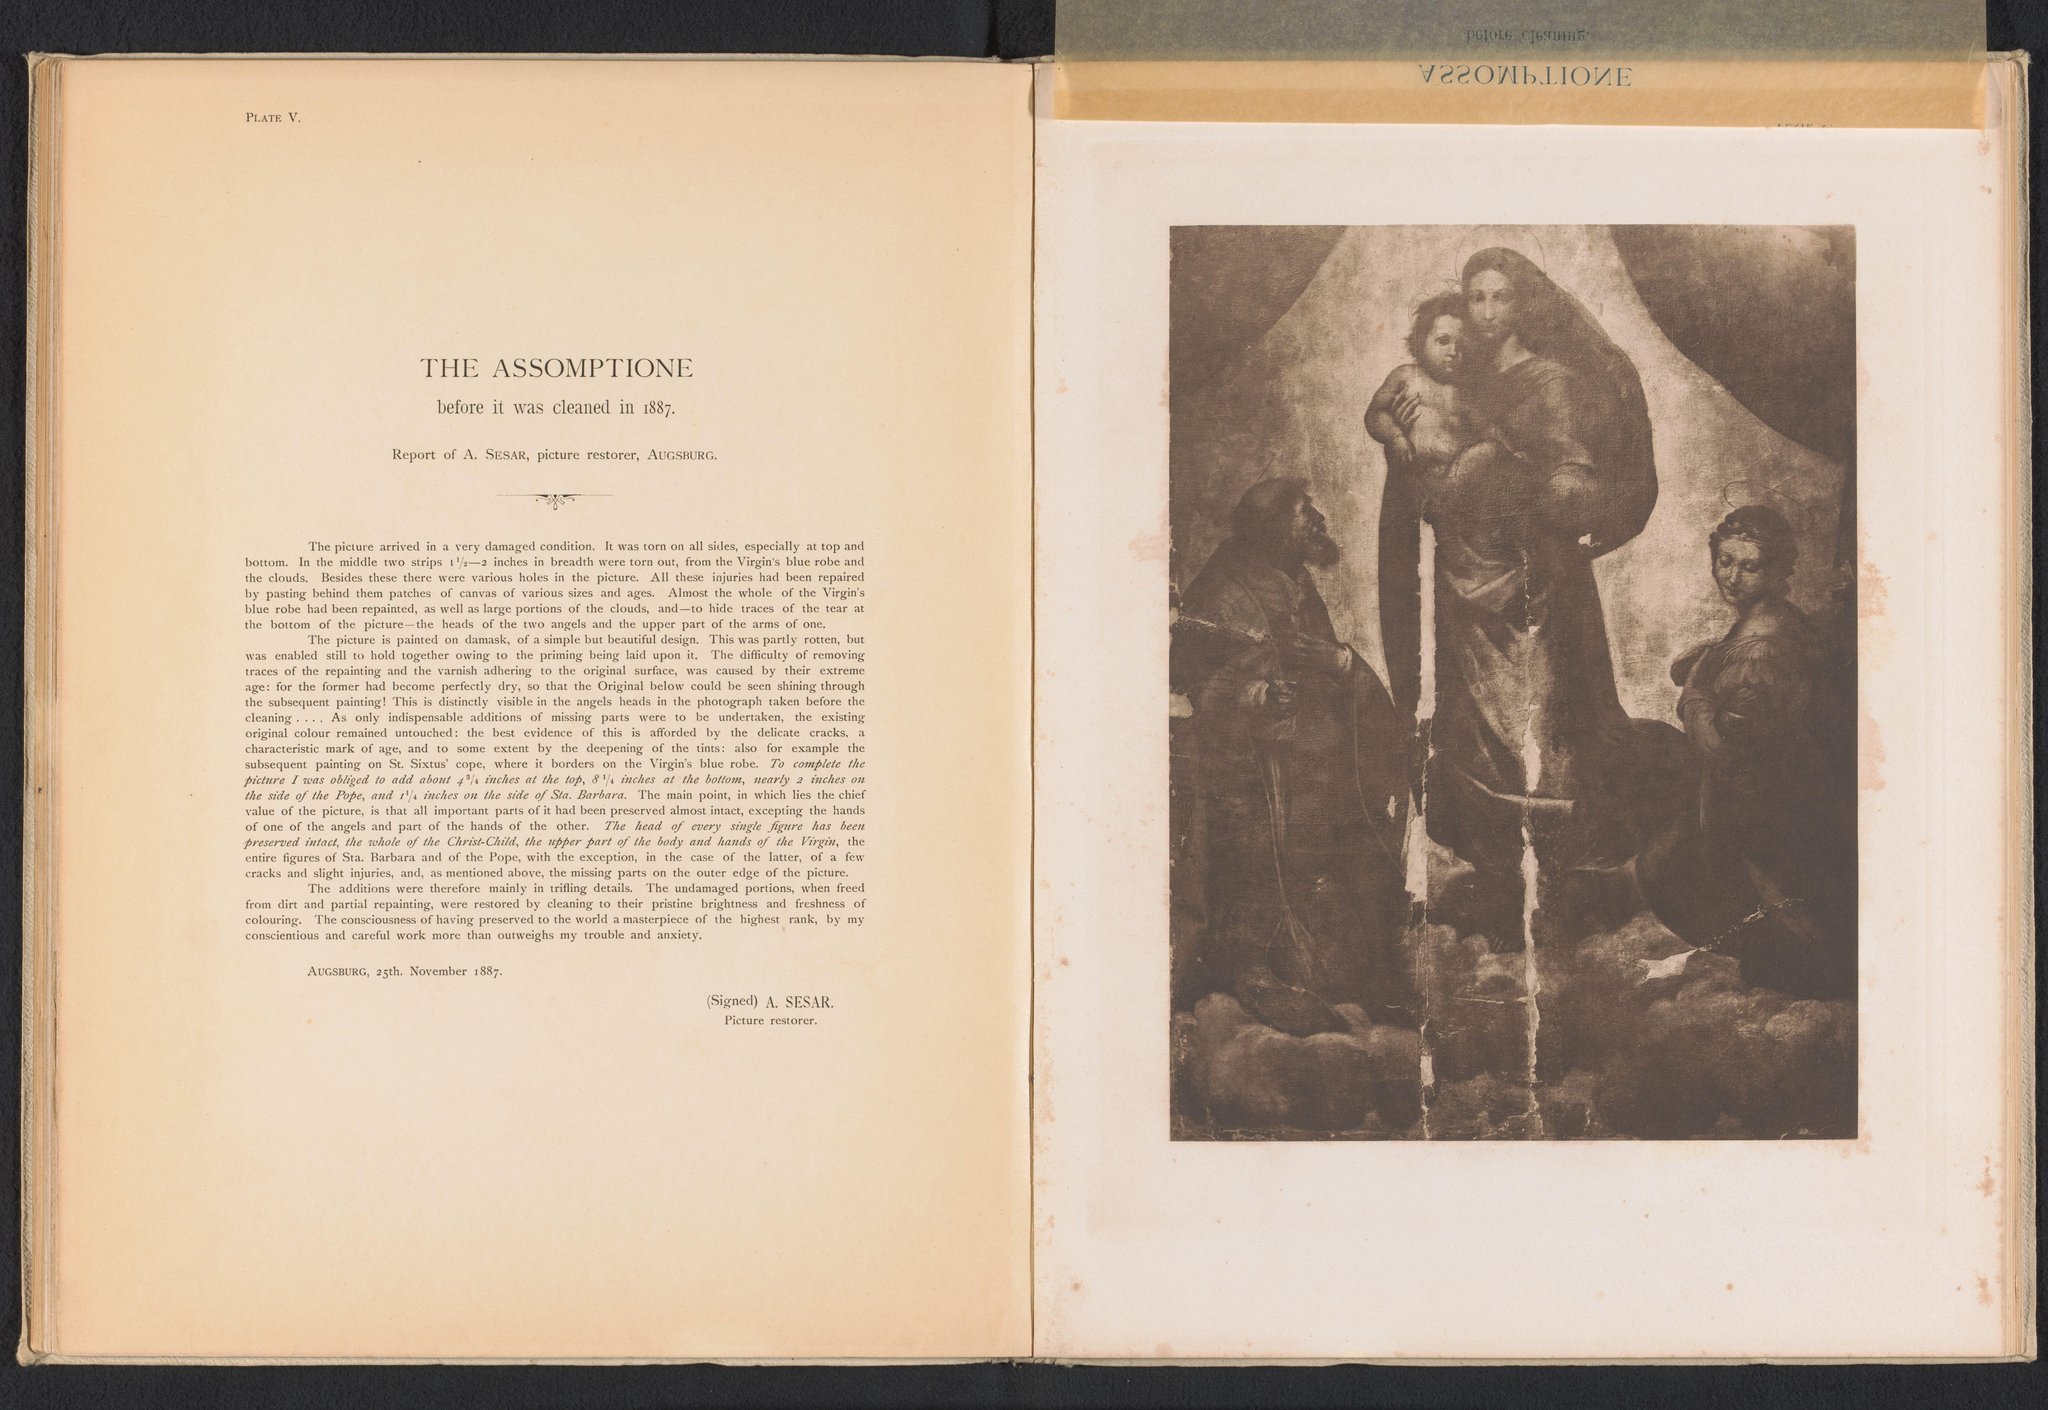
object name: page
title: Reproductie van een detail van de Sixtijnse Madonna door Rafaël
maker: g. höfle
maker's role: painter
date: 1890-1895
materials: paper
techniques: photoaquatint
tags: mary standing (or half-length), the christ-child in front of her, close to her bosom; sitting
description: Prent achter semi-transparante omslag met tekst.